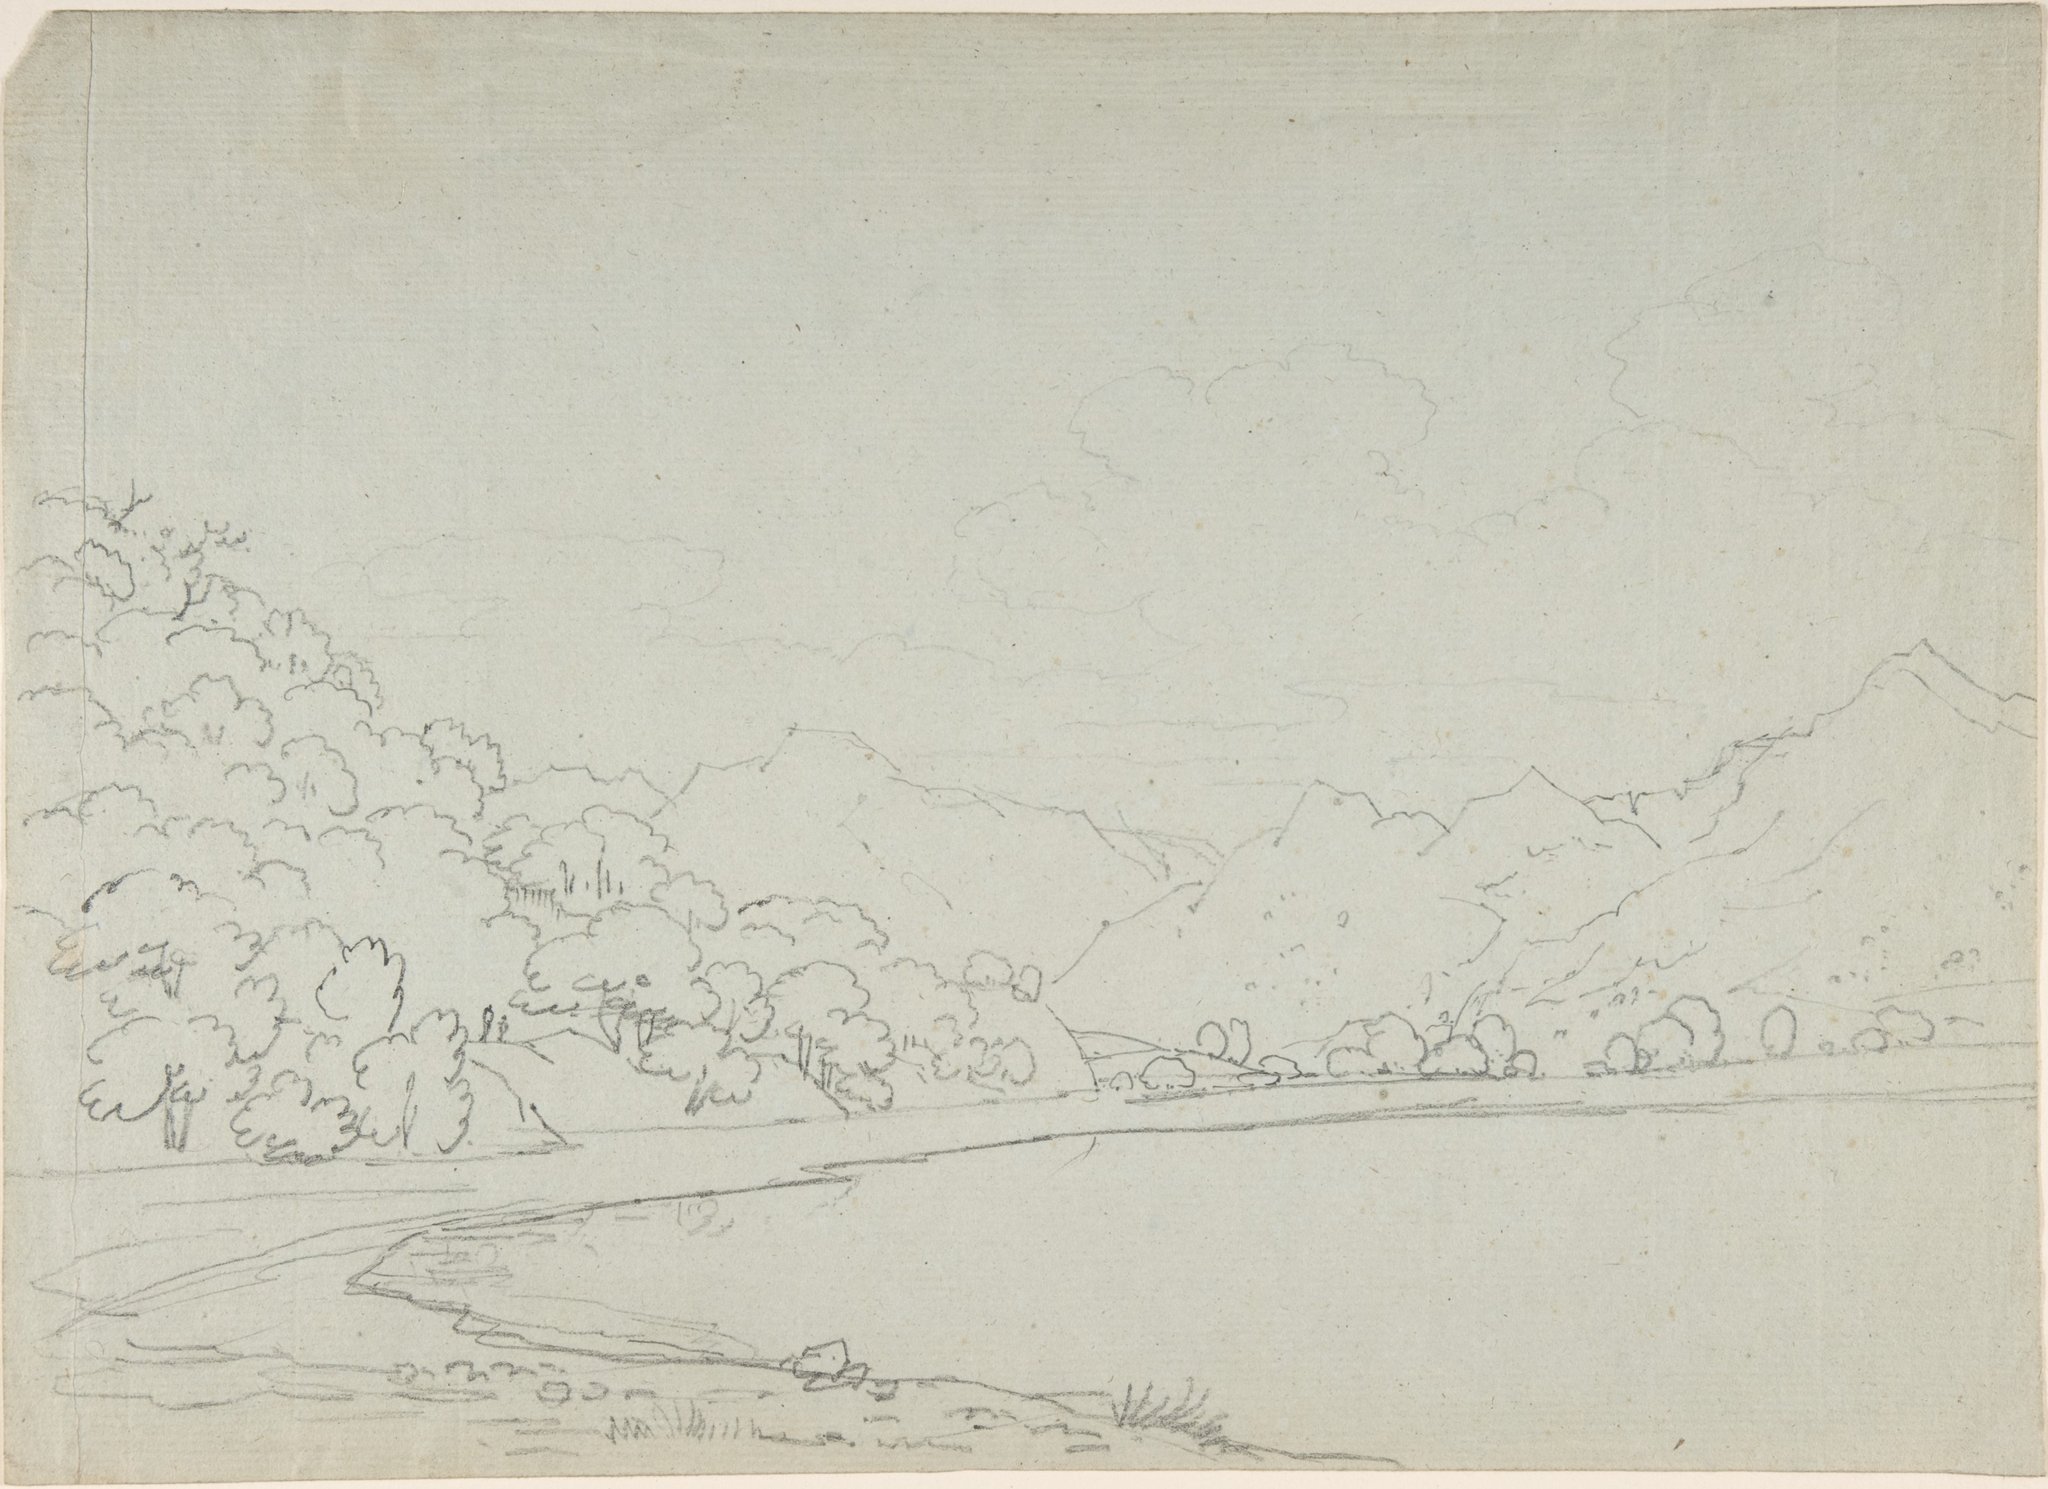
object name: drawing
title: On Brothers Water, Cumbria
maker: thomas sunderland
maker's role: artist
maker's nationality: british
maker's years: 1744-1828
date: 1764-1828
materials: chalk, graphite, paper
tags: landscapes